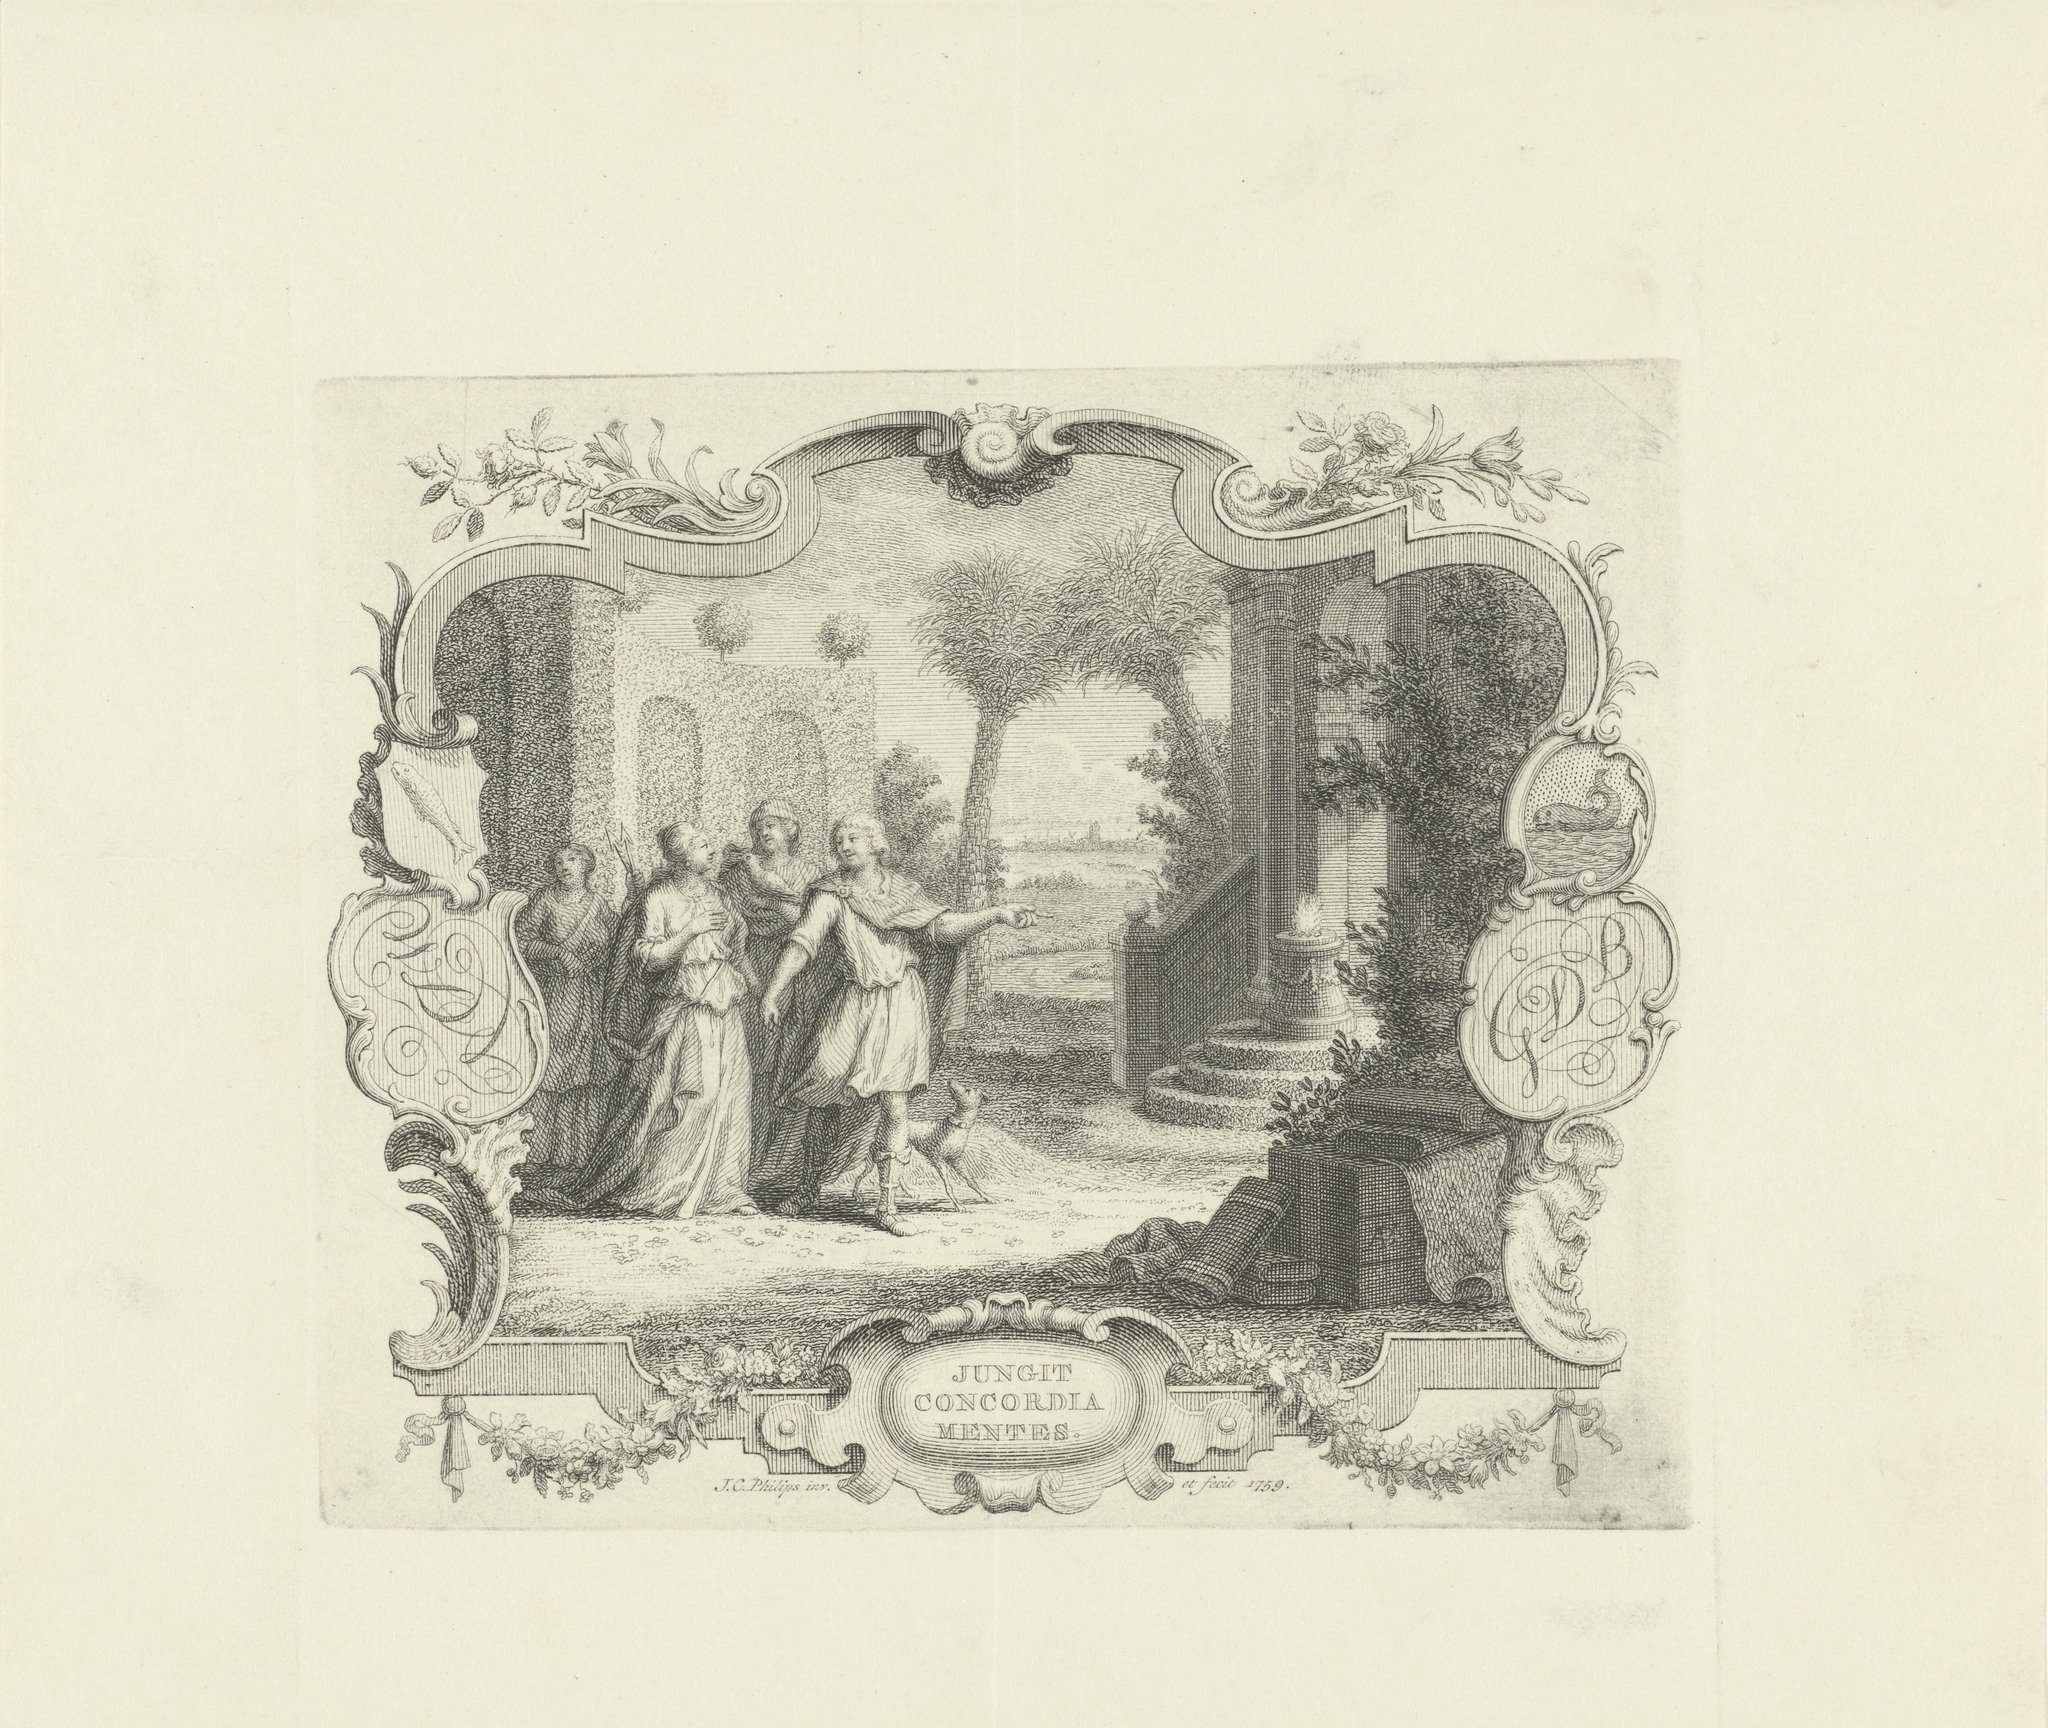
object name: vignette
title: Vignet op het huwelijk van Willem de Neve Abrahamsz. en Geertruide de Bruin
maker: jan caspar philips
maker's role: draughtsman, print maker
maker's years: 1700-1775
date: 1759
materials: paper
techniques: engraving, etching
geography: amsterdam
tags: agreement, unity; 'concordia', 'concordia insuperabile', 'concordia militare', 'concordia di pace', 'unione civile' (ripa), garden, marriage, married couple, 'matrimonium', dordrecht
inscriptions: collector's mark: Lugt 2228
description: Een pas getrouwd echtpaar wandelt door een tuin. De man wijst op een vlam die naar hun liefde verwijst. Ze worden vergezeld door de gepersonifieerde Eendracht en een vrouw met een duif op de hand, die verwijst naar de huwelijkstrouw. Op de achtergrond een gezicht op Dordrecht, de plaats waar het echtpaar getrouwd is. De voorstelling is gevat in een cartouche met de wapens en initialen van het echtpaar.